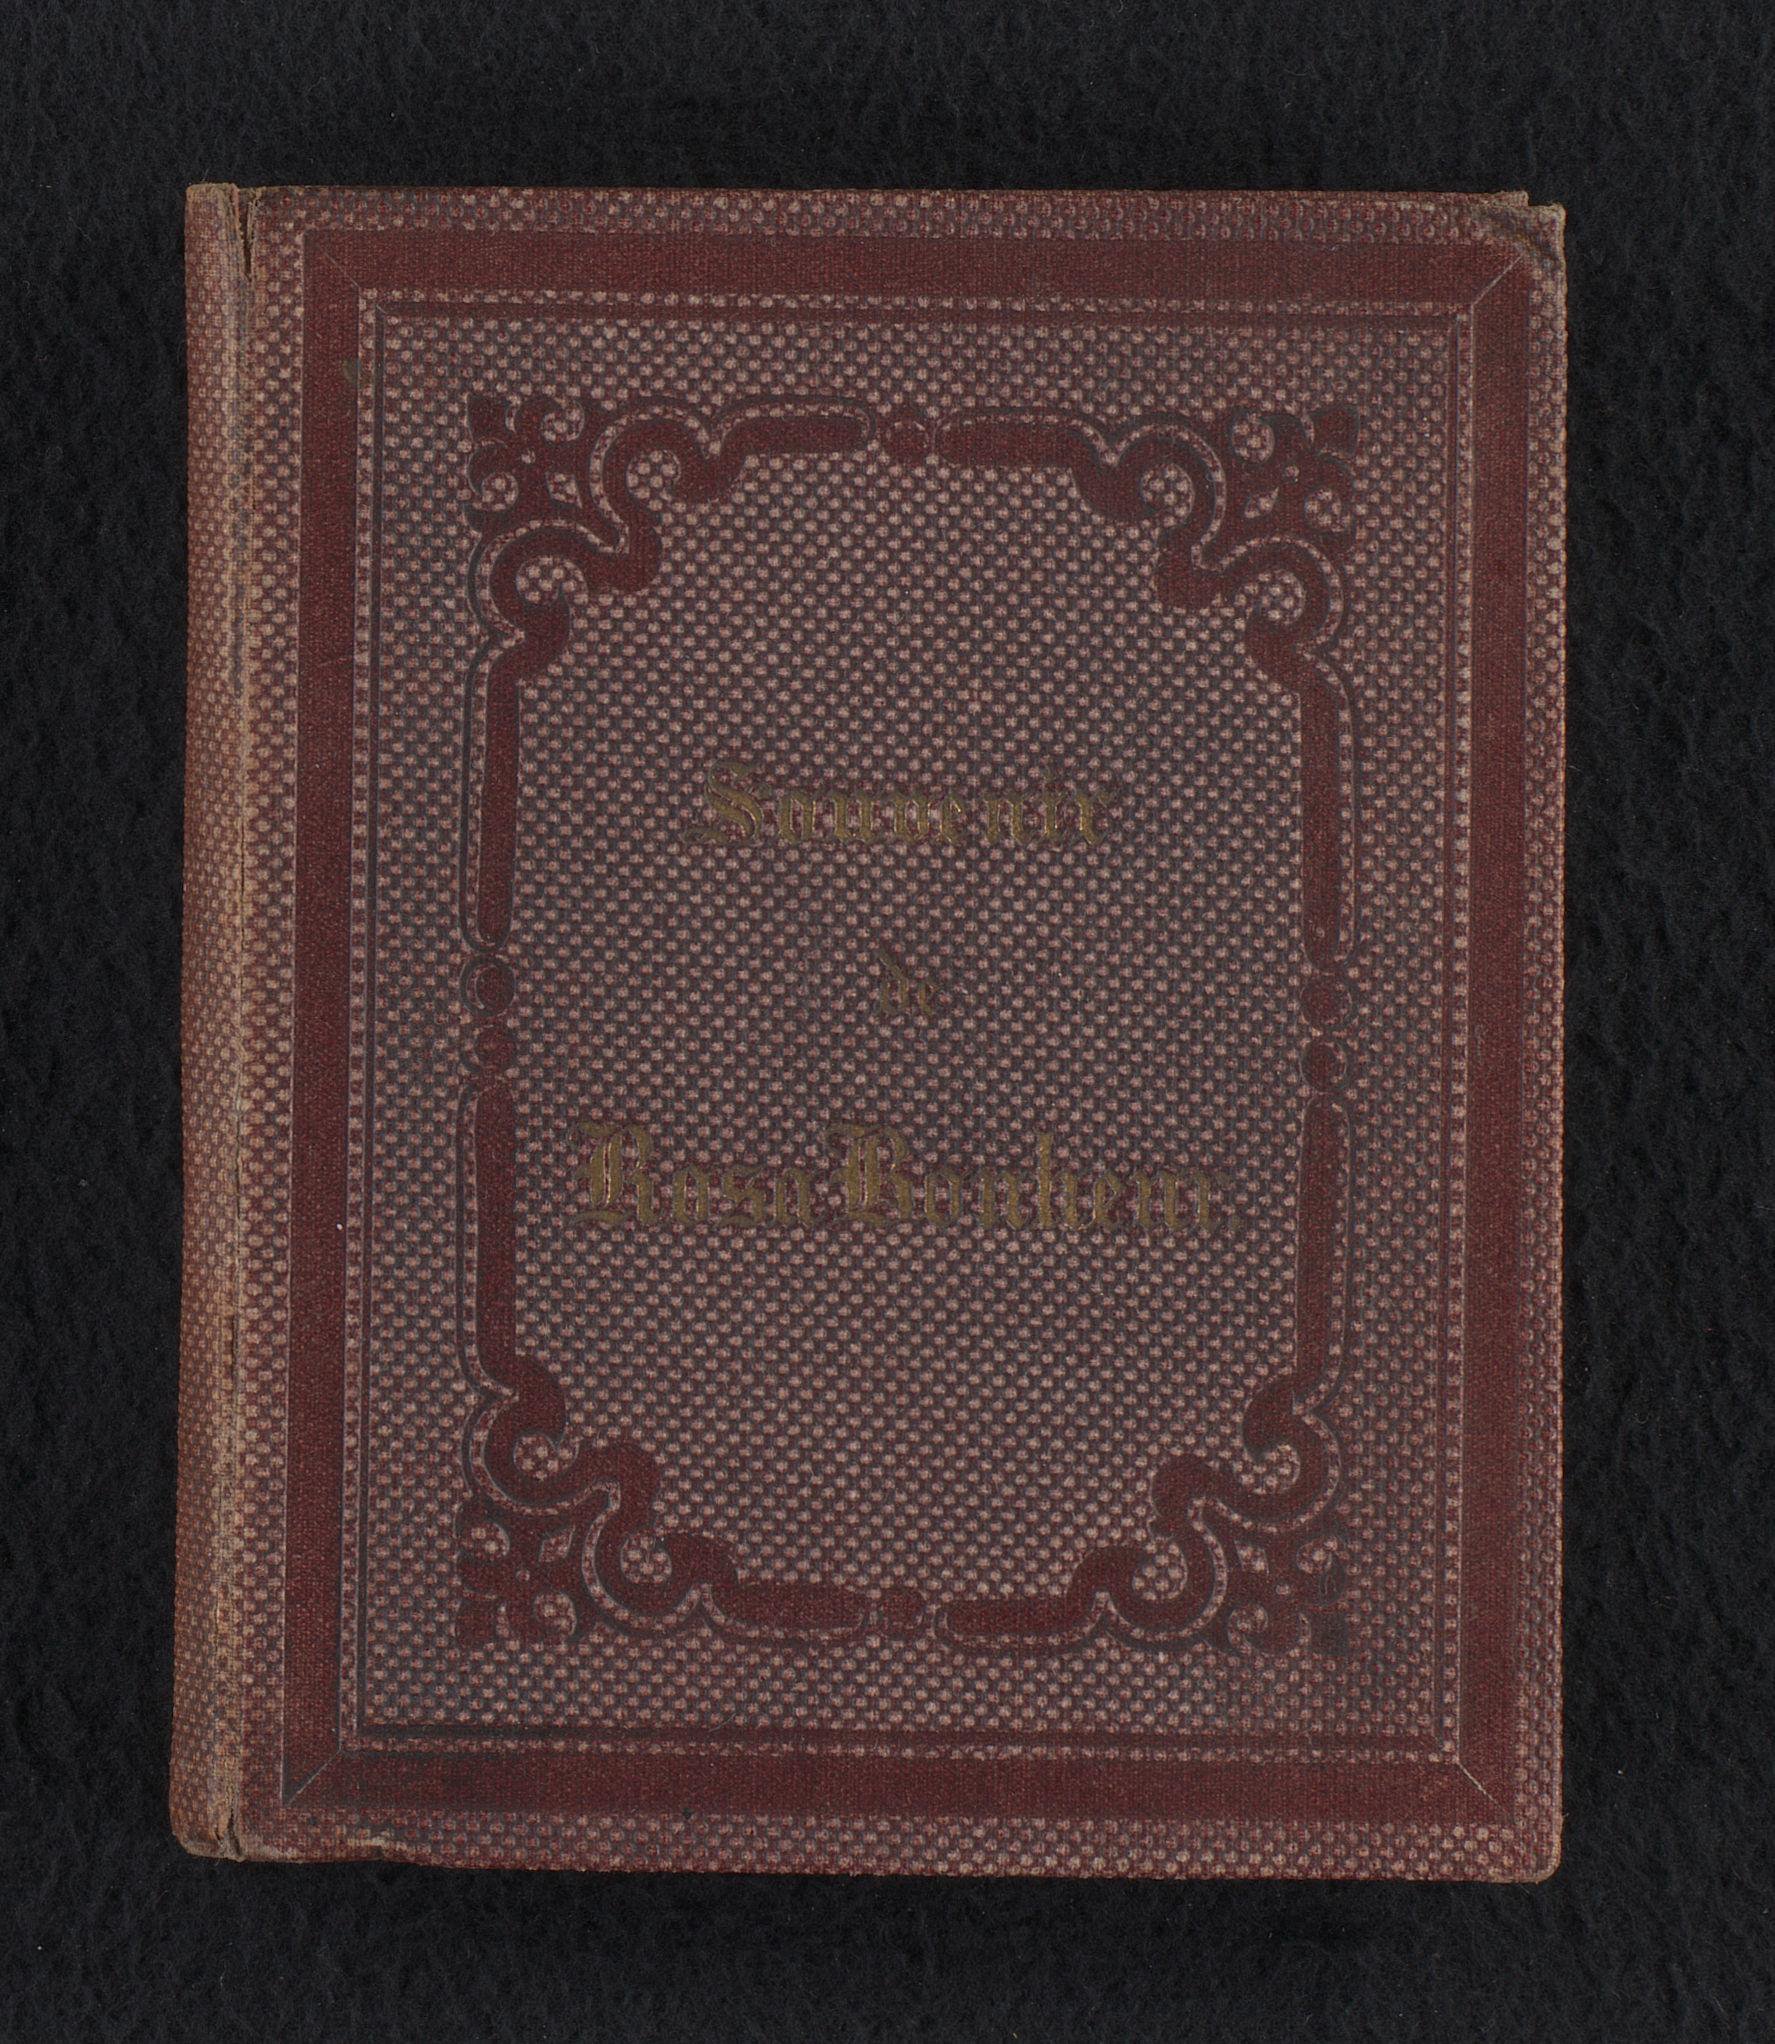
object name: book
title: Souvenir de Rosa Bonheur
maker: Anonymous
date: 1890-1900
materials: cardboard, paper, textile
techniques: albumen print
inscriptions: inscription: ‘M. Maingay-/ Dalen/ aan/ C. Maingay’, inscription: ‘izl. 360’